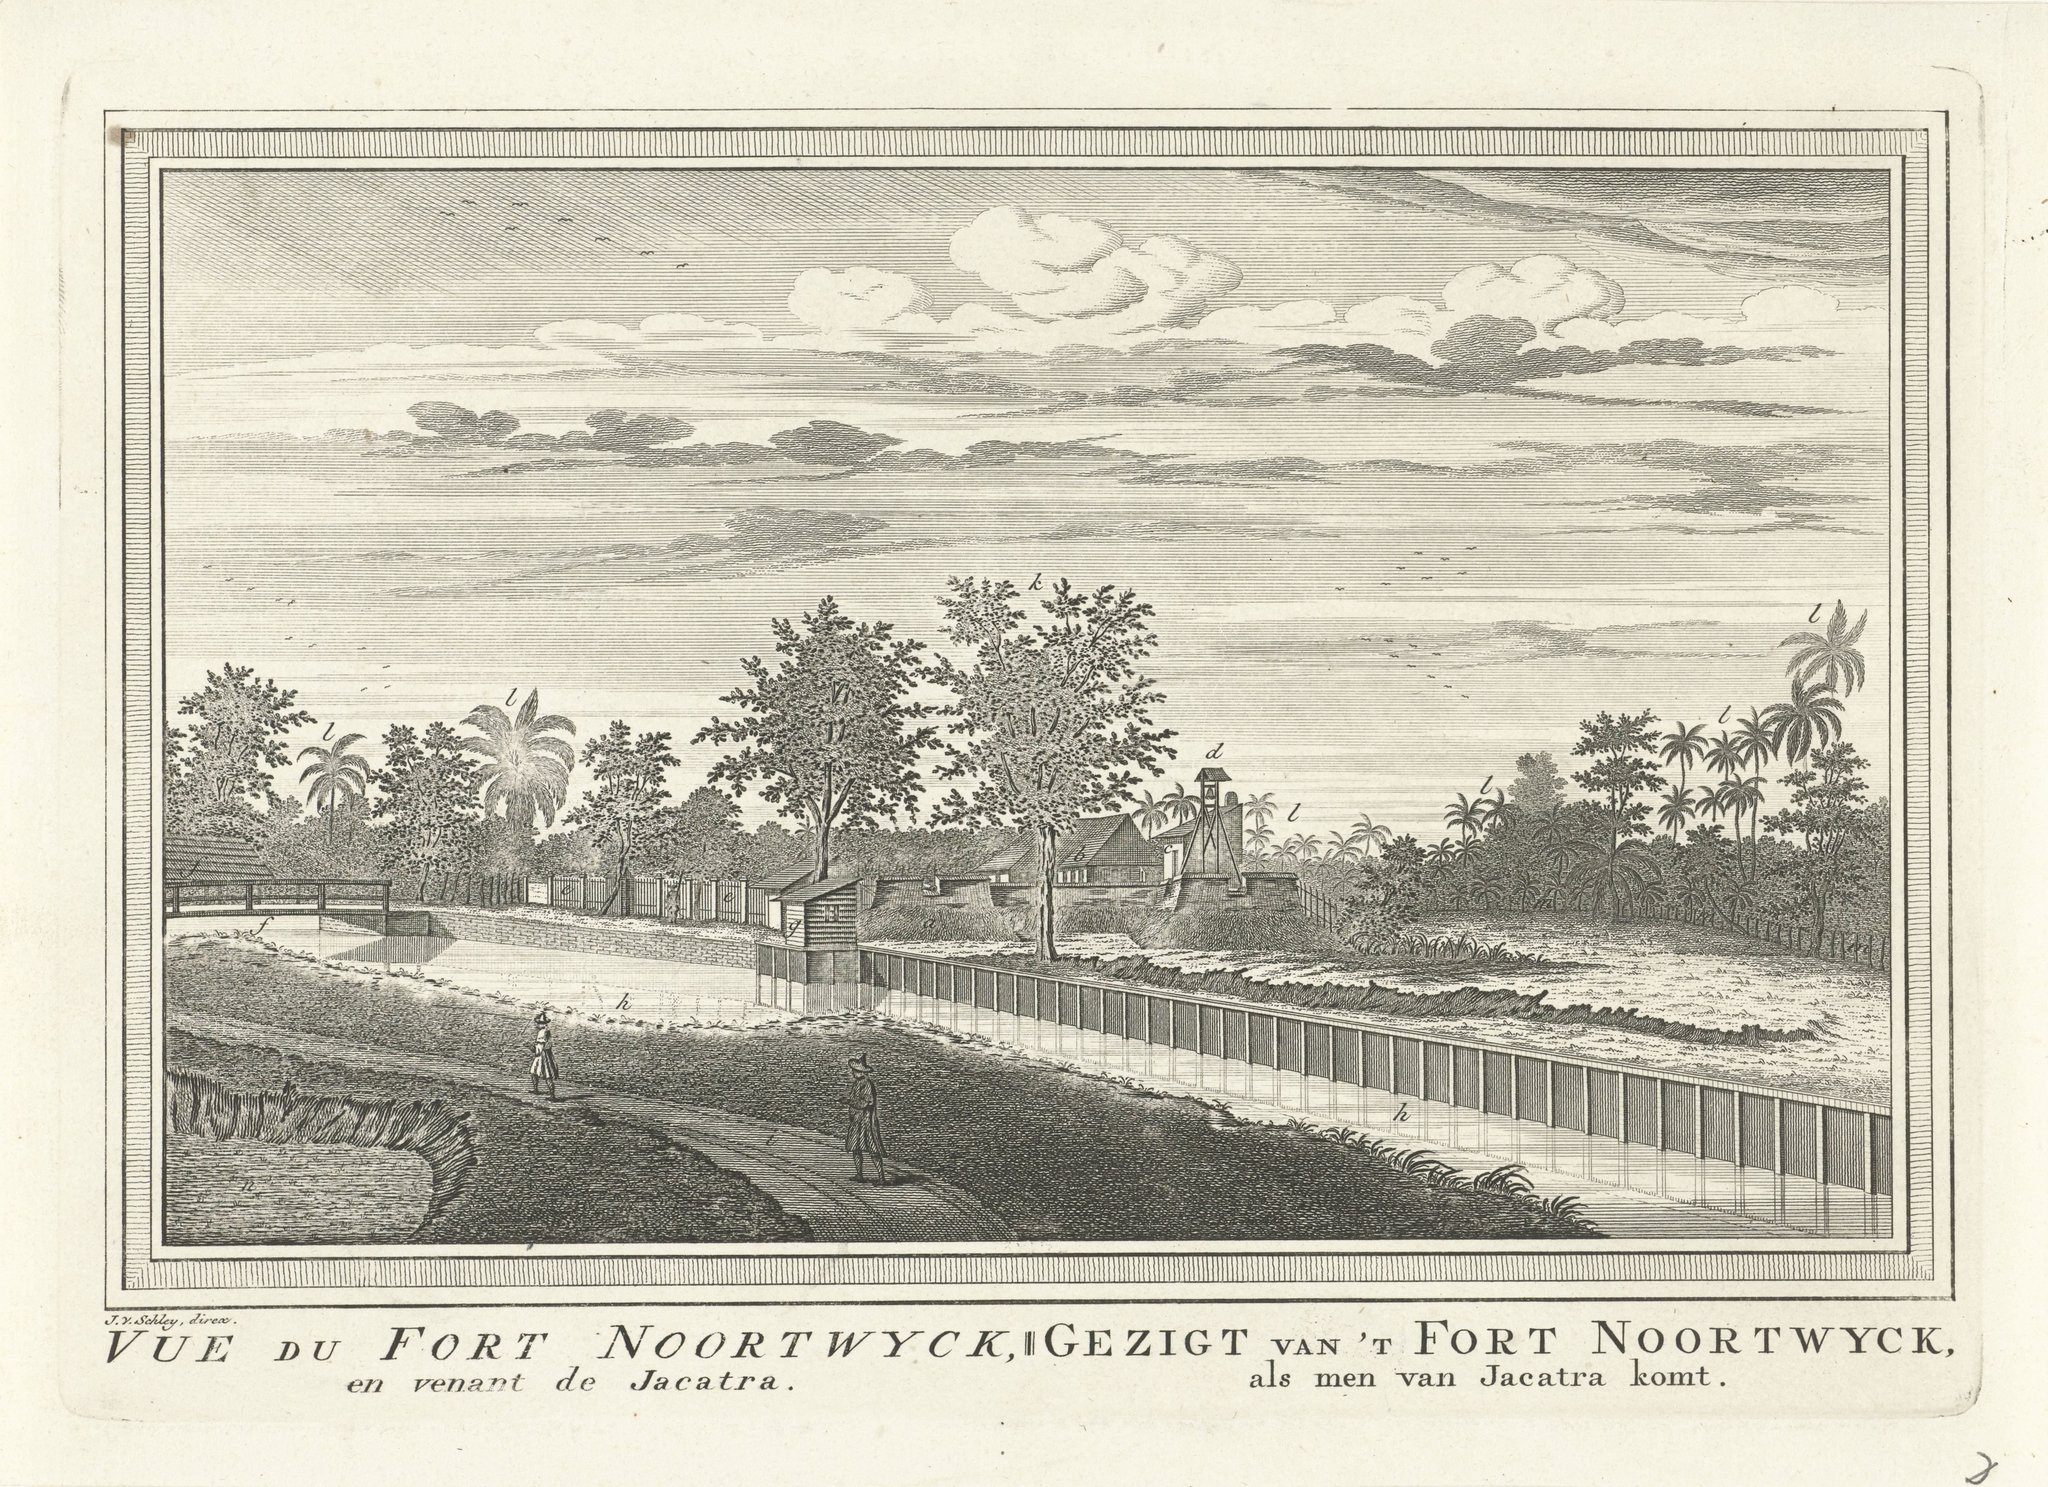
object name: book illustration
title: Gezicht op fort Noordwijk in Jakarta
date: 1747-1779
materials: paper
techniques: engraving, etching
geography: amsterdam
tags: fortifications, military engineering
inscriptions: collector's mark: Lugt 2228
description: Illustratie in: Bois, J.P.J. du: Histoire Générale Des Voyages, Ou Nouvelle Collection De Toutes Les Relations De Voyages Par Mer Et Par Terre, deel XVII, Den Haag: Pierre de Hondt, 1747- 1779, na p. 264.